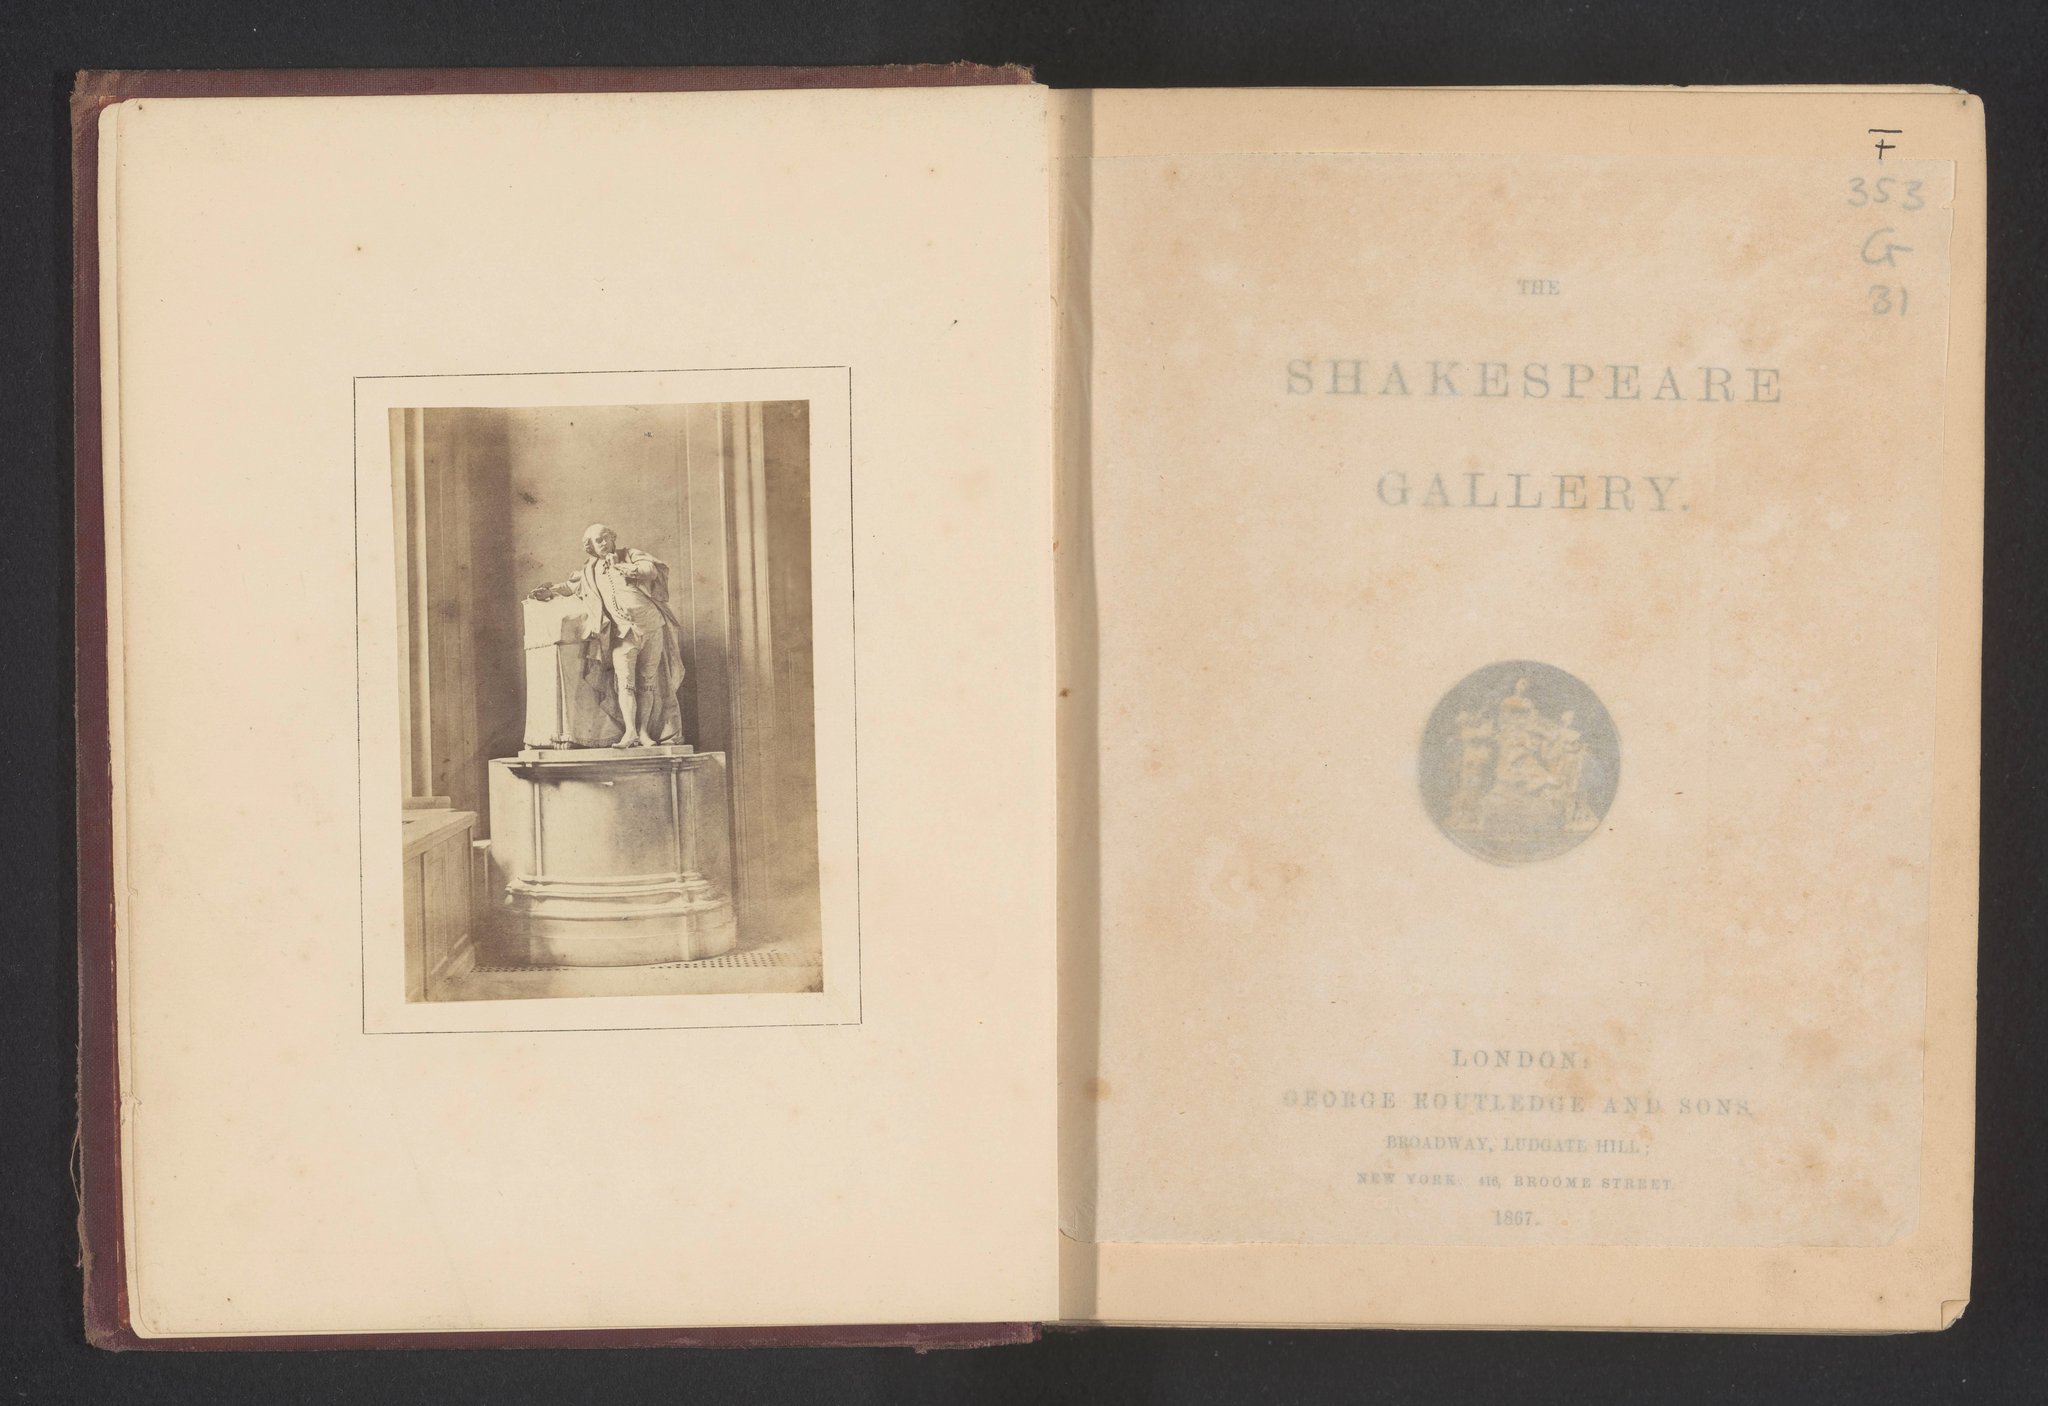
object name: page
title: Standbeeld van William Shakespeare door Louis Francois Roubiliac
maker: stephen ayling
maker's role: fotograaf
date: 1854-1867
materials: photographic support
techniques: albumen print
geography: london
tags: william shakespeare, monument, statue